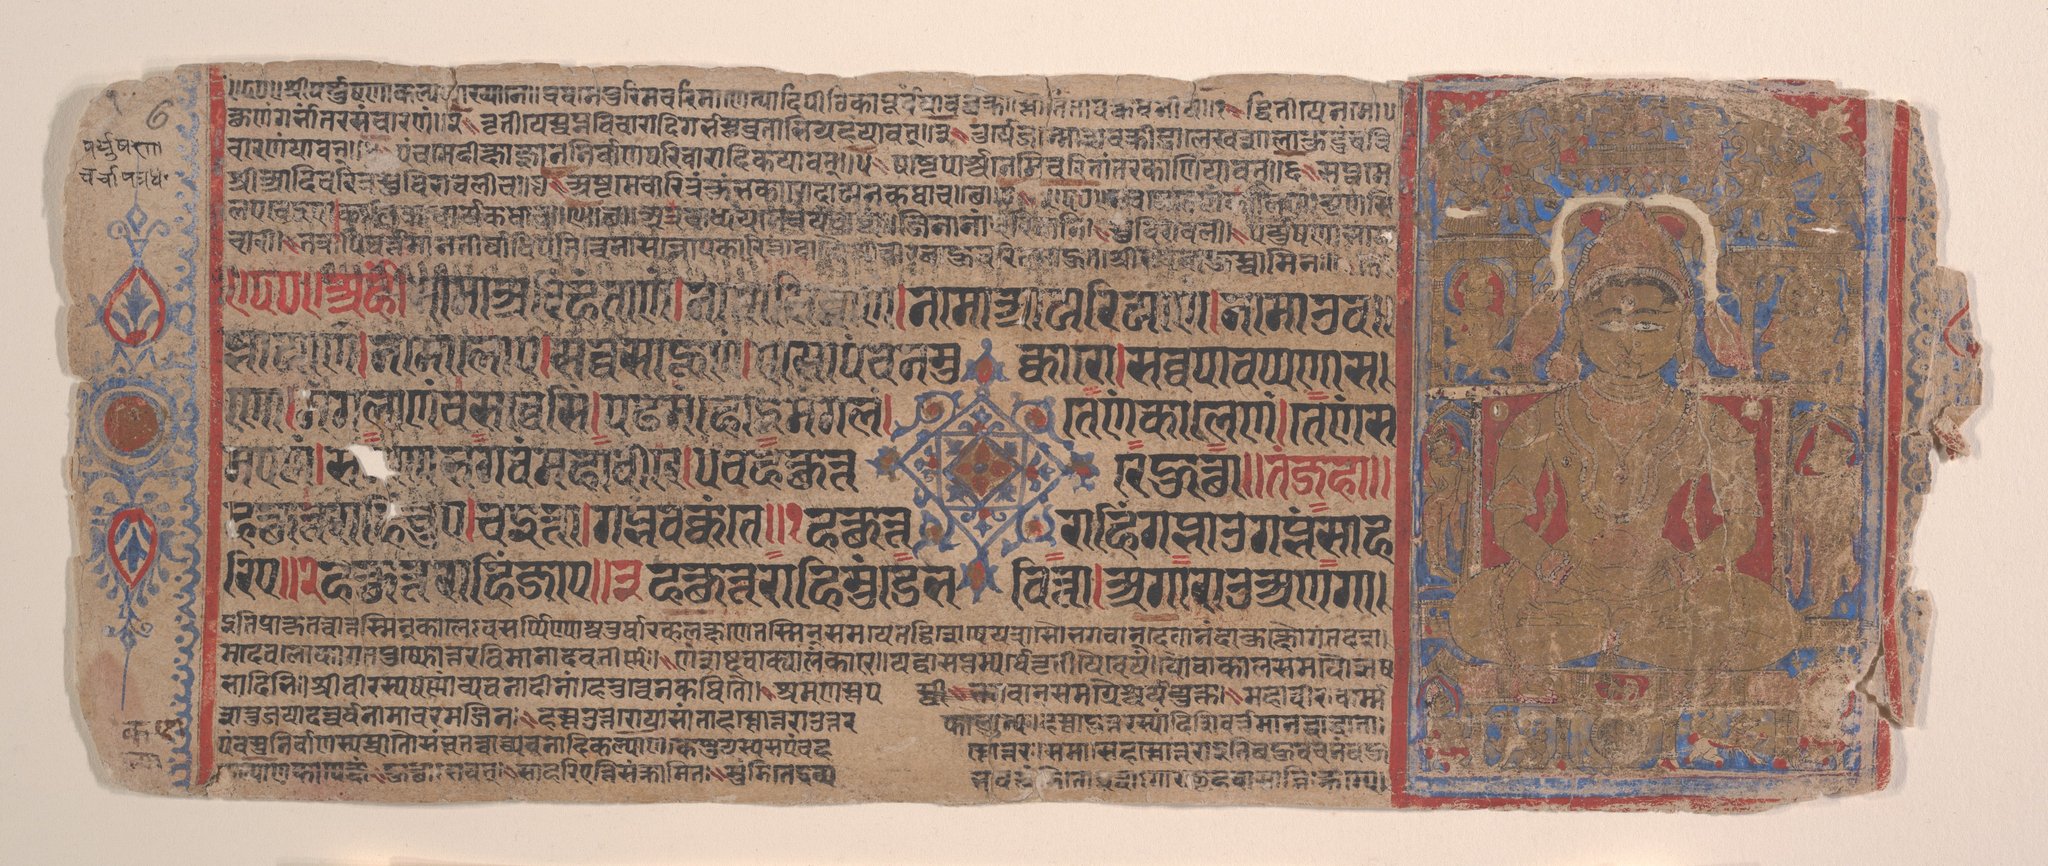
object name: folio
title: Leaf from a Kalpa Sutra (Jain Book of Rituals)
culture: indian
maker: bhadrabahu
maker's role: artist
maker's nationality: indian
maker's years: 356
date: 1401-1500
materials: gold, ink, paper, watercolor